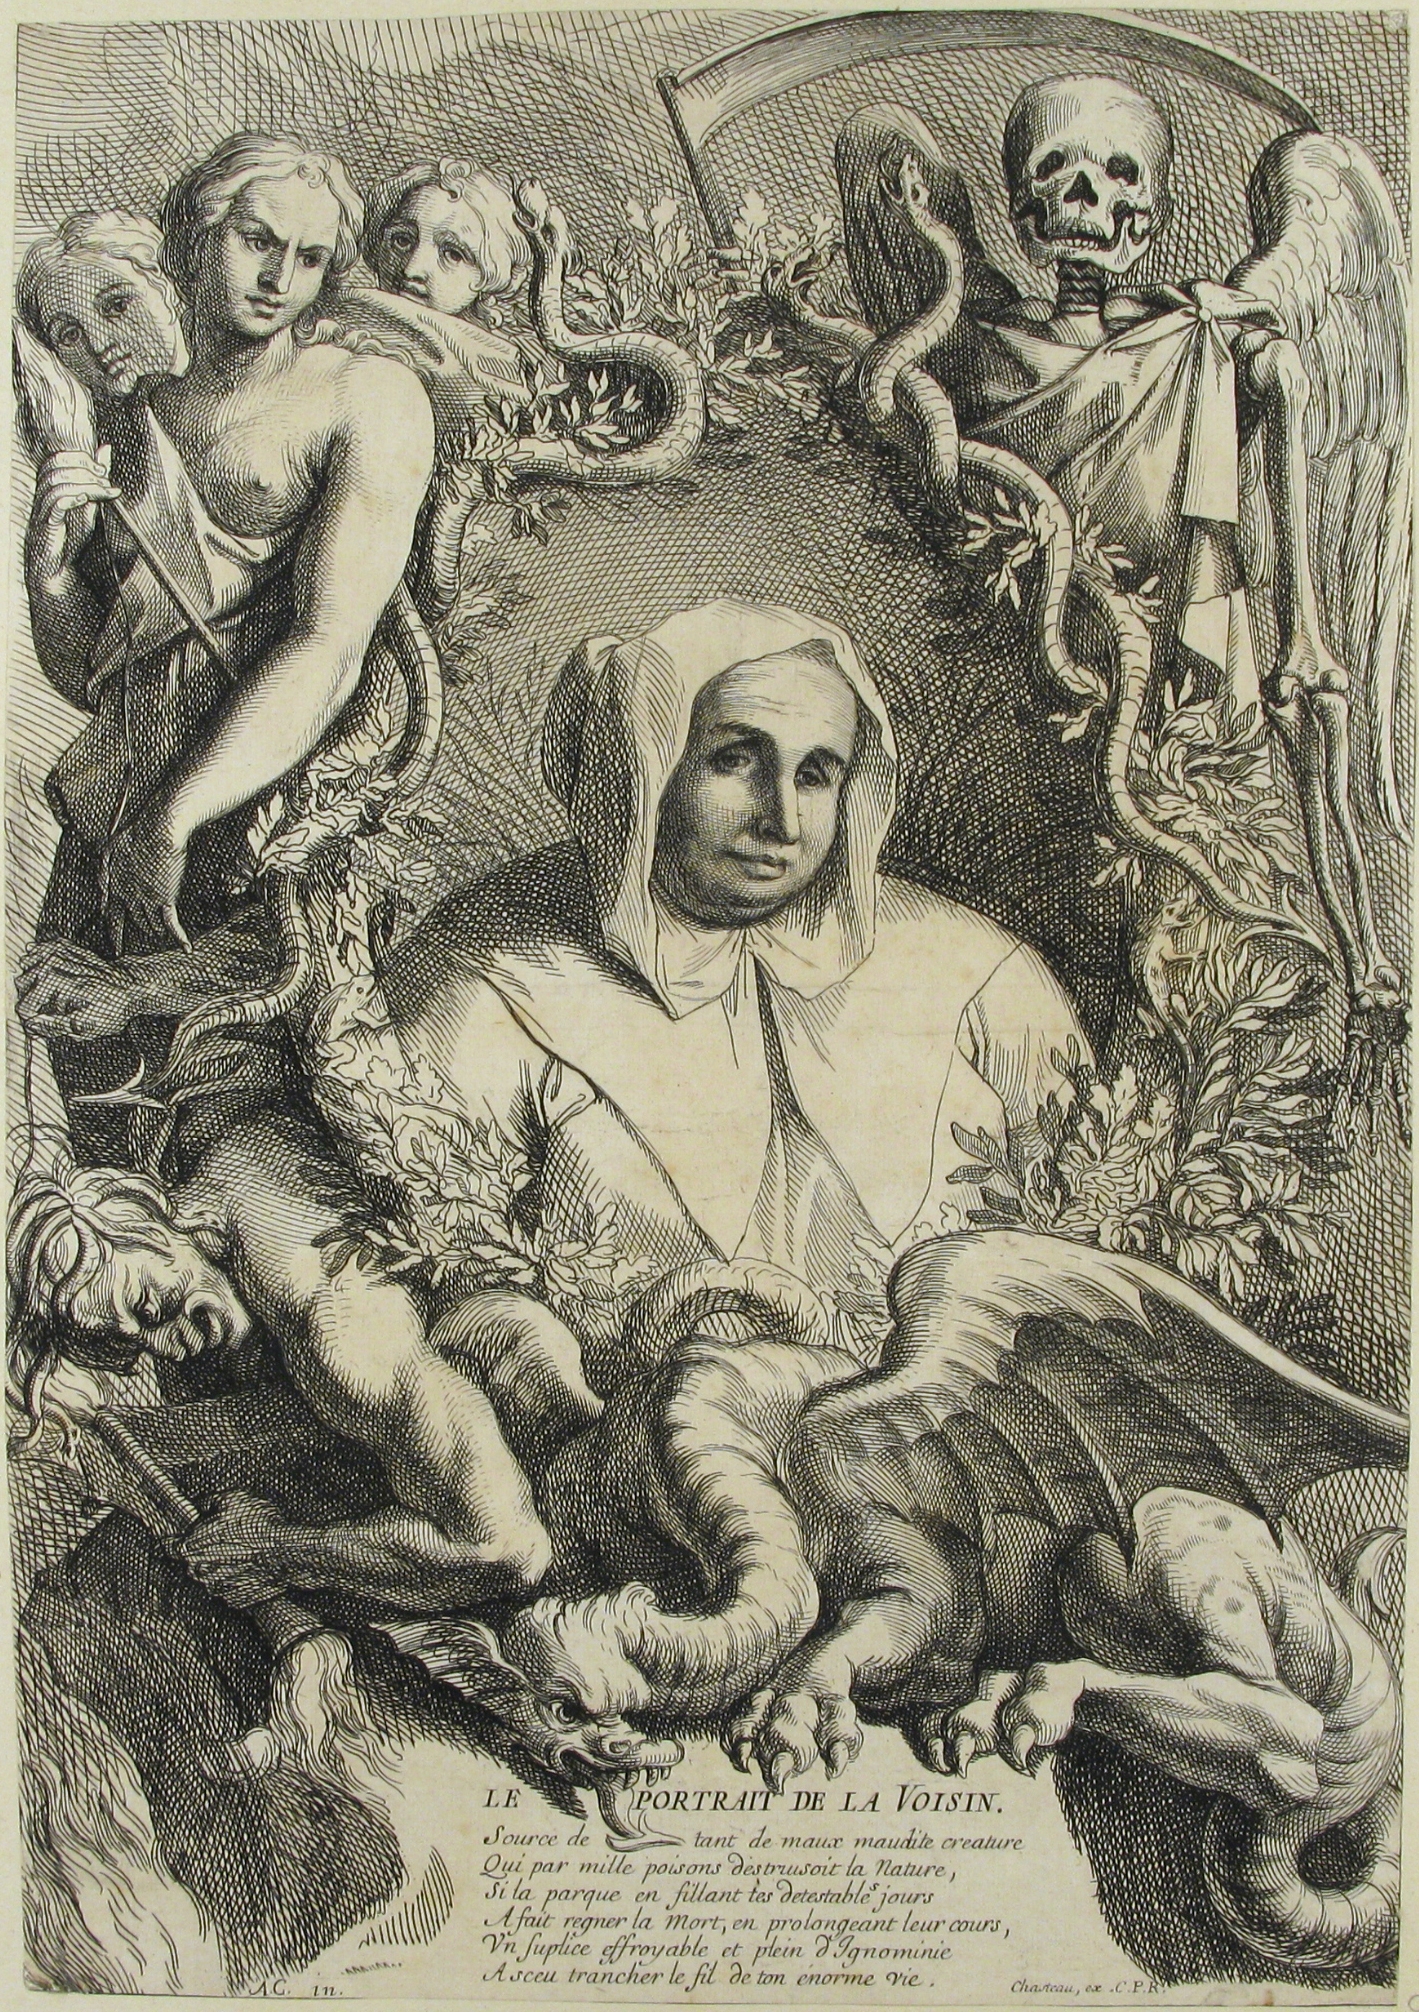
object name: print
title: Portrait of la Voisin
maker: antoine coypel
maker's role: artist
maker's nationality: french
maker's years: 1661-1722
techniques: etching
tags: portraits,women,female nudes,dragons